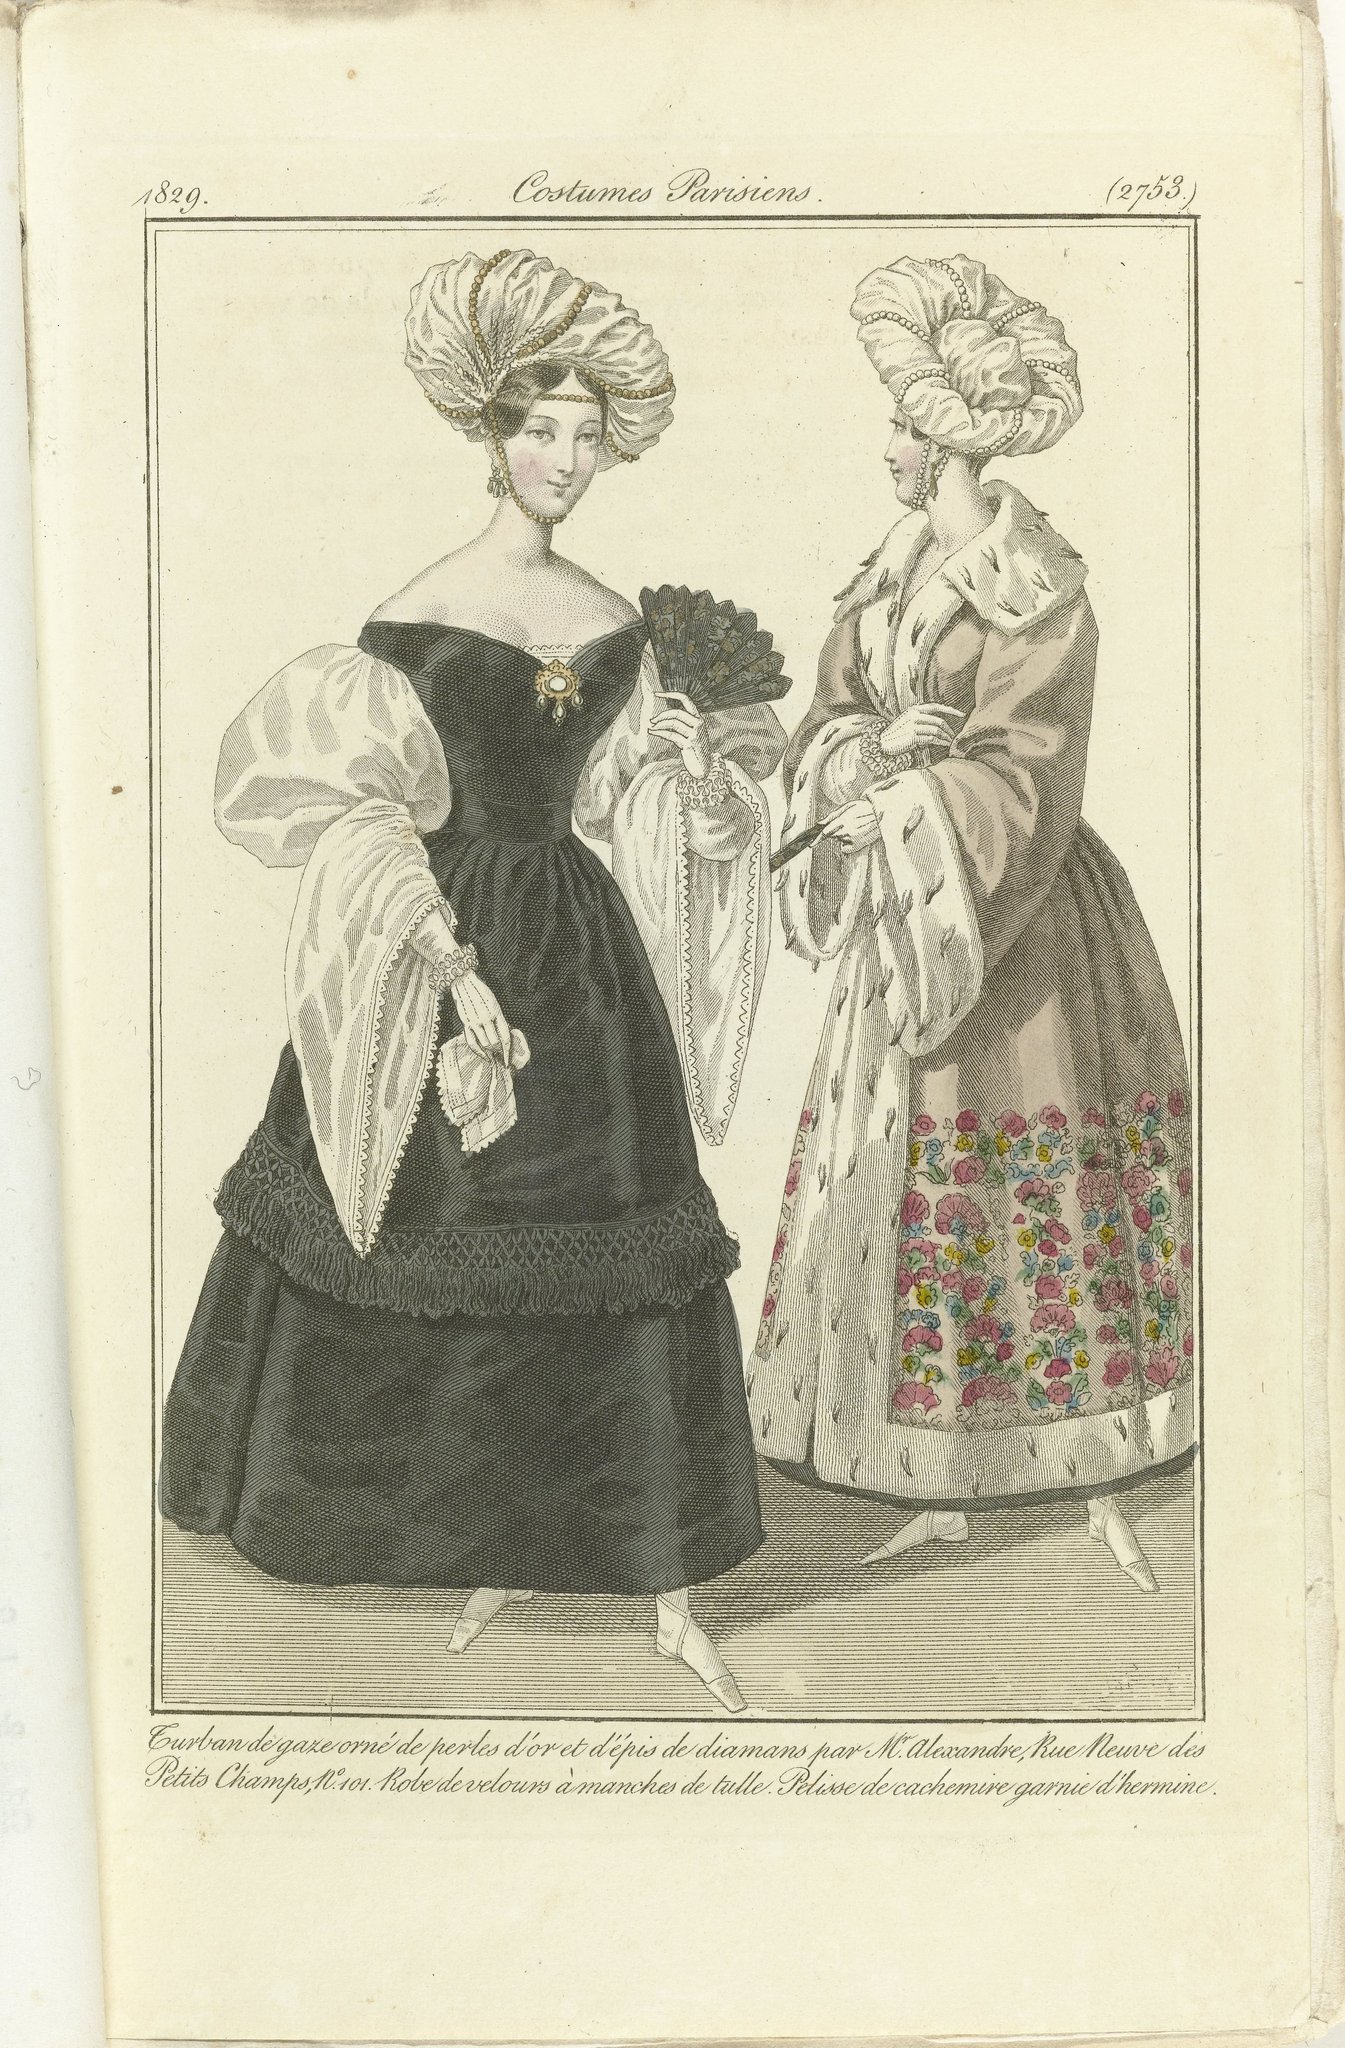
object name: fashion print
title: Journal des Dames et des Modes 1829, Costumes Parisiens (2753)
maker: Anonymous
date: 1829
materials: paper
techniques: etching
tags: fashion plates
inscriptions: date